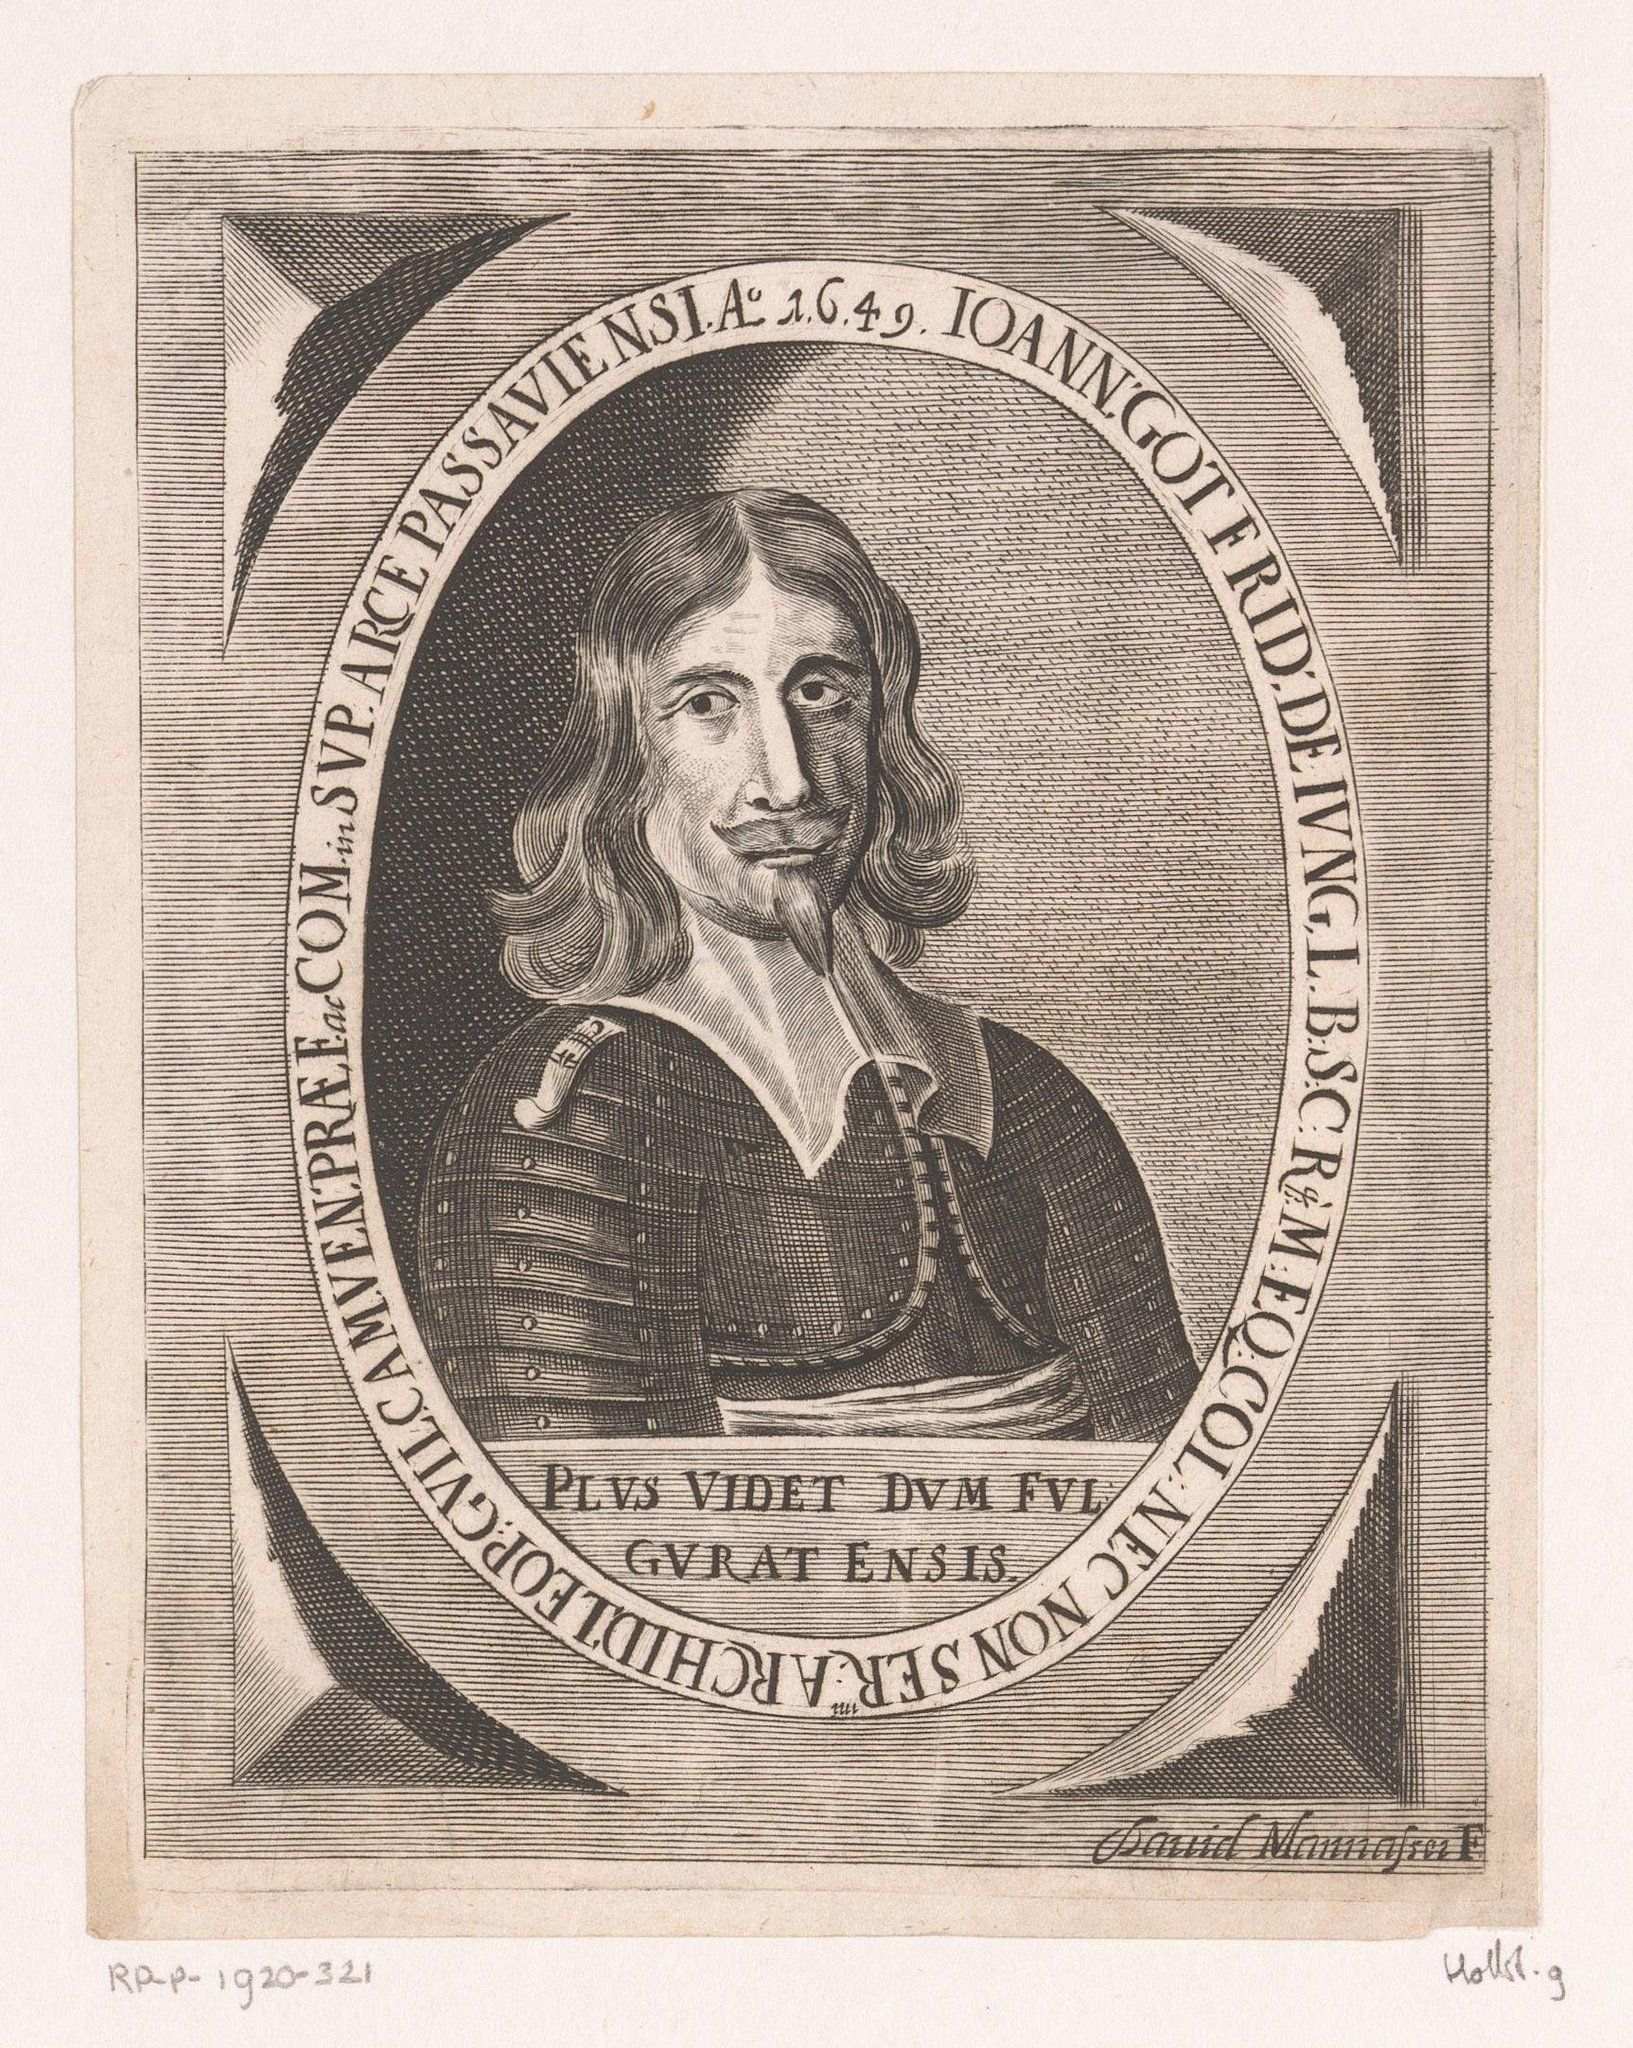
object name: print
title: Portret van Johann Gottfried de jongere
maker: david mannasser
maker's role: print maker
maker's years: -1664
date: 1649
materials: paper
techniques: engraving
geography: germany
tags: historical persons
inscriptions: collector's mark: Lugt 2228